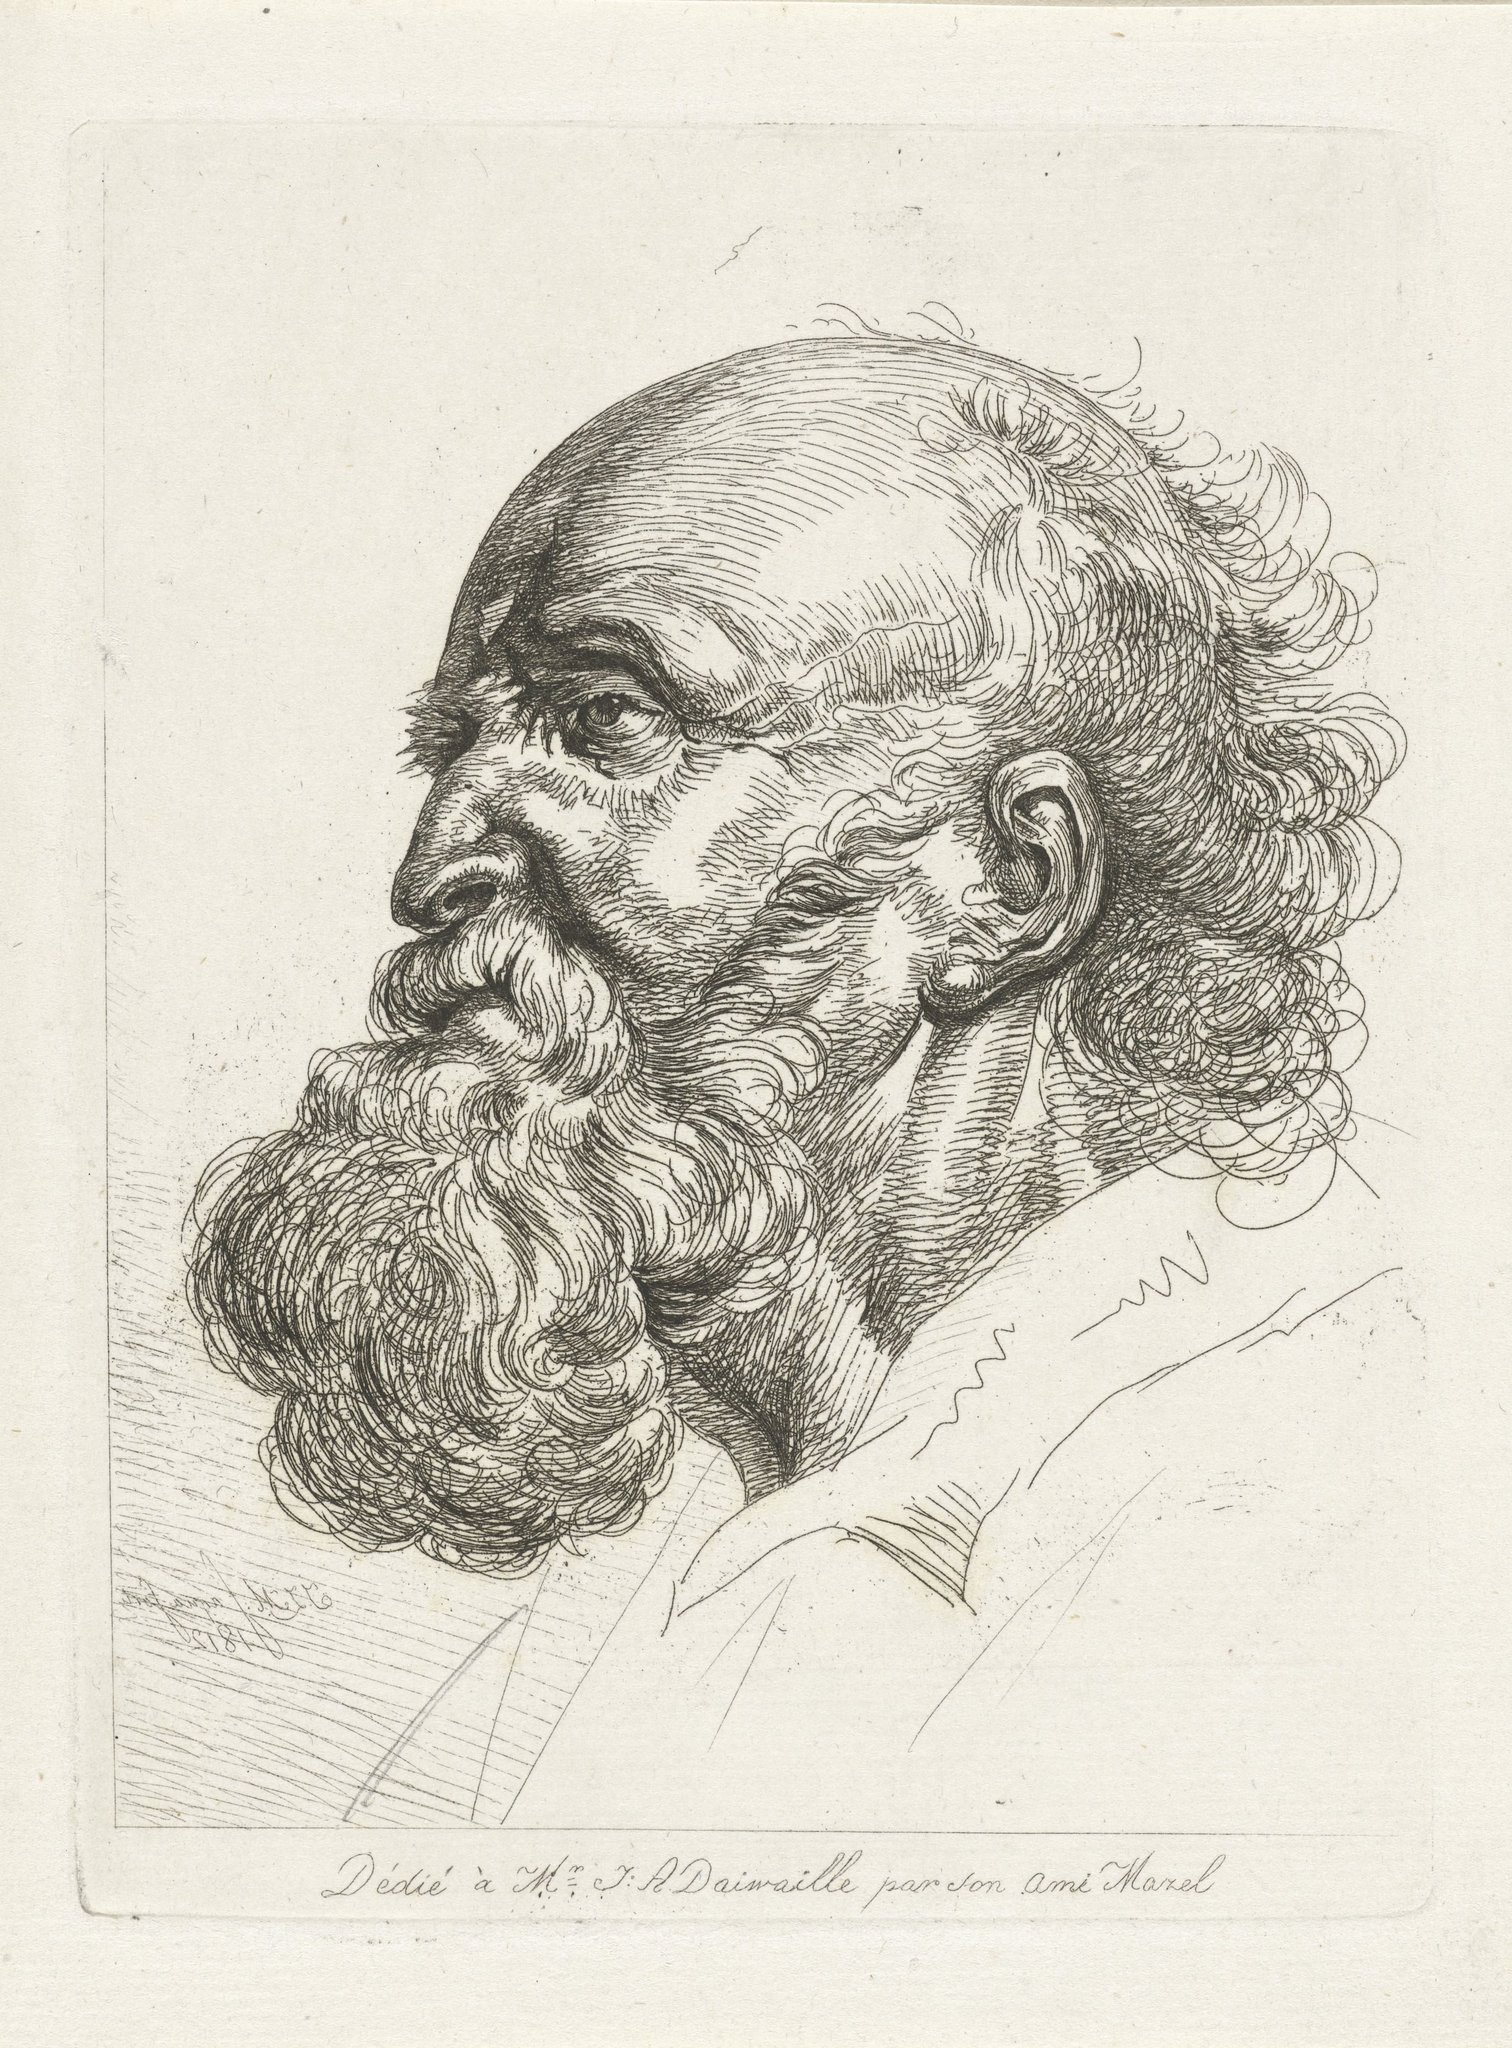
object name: print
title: Portret van een oude man met baard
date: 1812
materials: paper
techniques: etching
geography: netherlands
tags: old man, beard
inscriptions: collector's mark: Lugt 2760, collector's mark: Lugt 2228